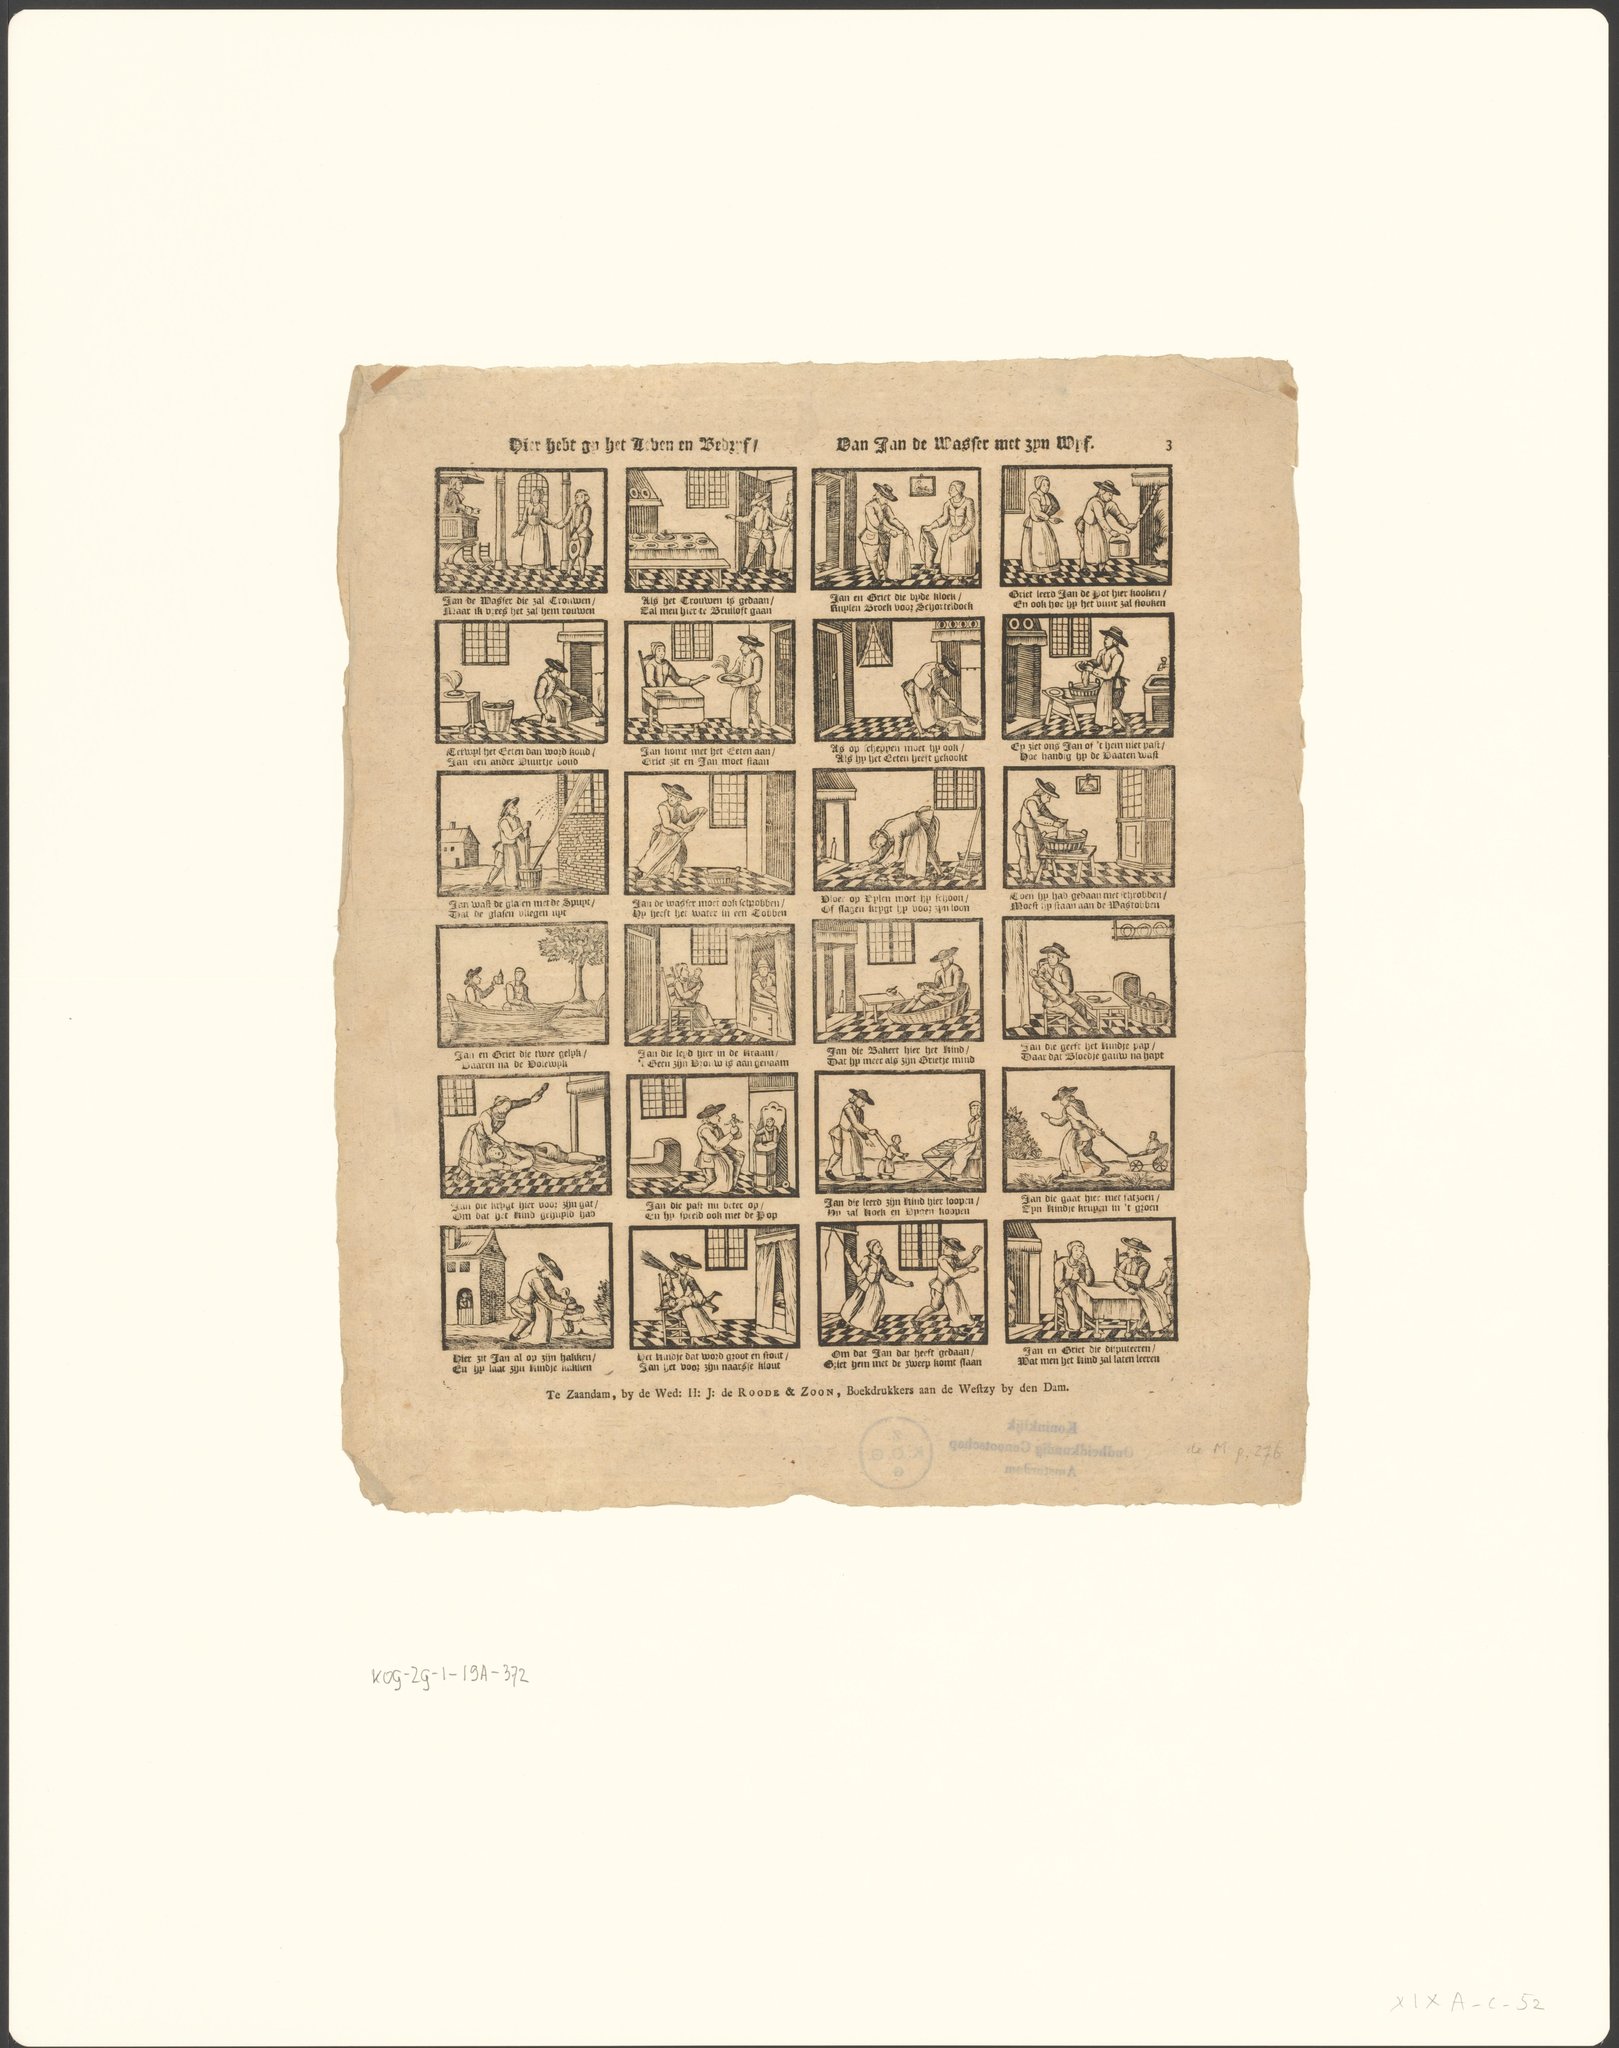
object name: print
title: Leven en werk van Jan de Wasscher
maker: Anonymous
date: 1792-1803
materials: paper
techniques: letterpress printing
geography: zaltbommel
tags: hen-pecked husband, 'betty', 'molly' (man who engages in women's work), battle for dominance in marriage ('who wears the breeches'), pulpit, ambo, chancel, cradle, crib, whip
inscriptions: stamp: ‘Koninklijk Oudheidkundig Genootschap Amsterdam’, collector's mark: Lugt 1641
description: Blad met 24 voorstellingen uit het leven van Jan de Wasser, een man die van zijn vrouw Griet, die de broek aan heeft, al het huishoudelijk werk moet doen. Onder elke afbeelding een tweeregelig vers. Genummerd rechtsboven: 3. Onderwerpsrubrieken binnen de Atlas Zeden en Gewoonten: Zeden en Gewoonten in Engeren Zin, Des menschen beging, midden en einde, Kinderleven – Kinderspel en Kinderprenten.